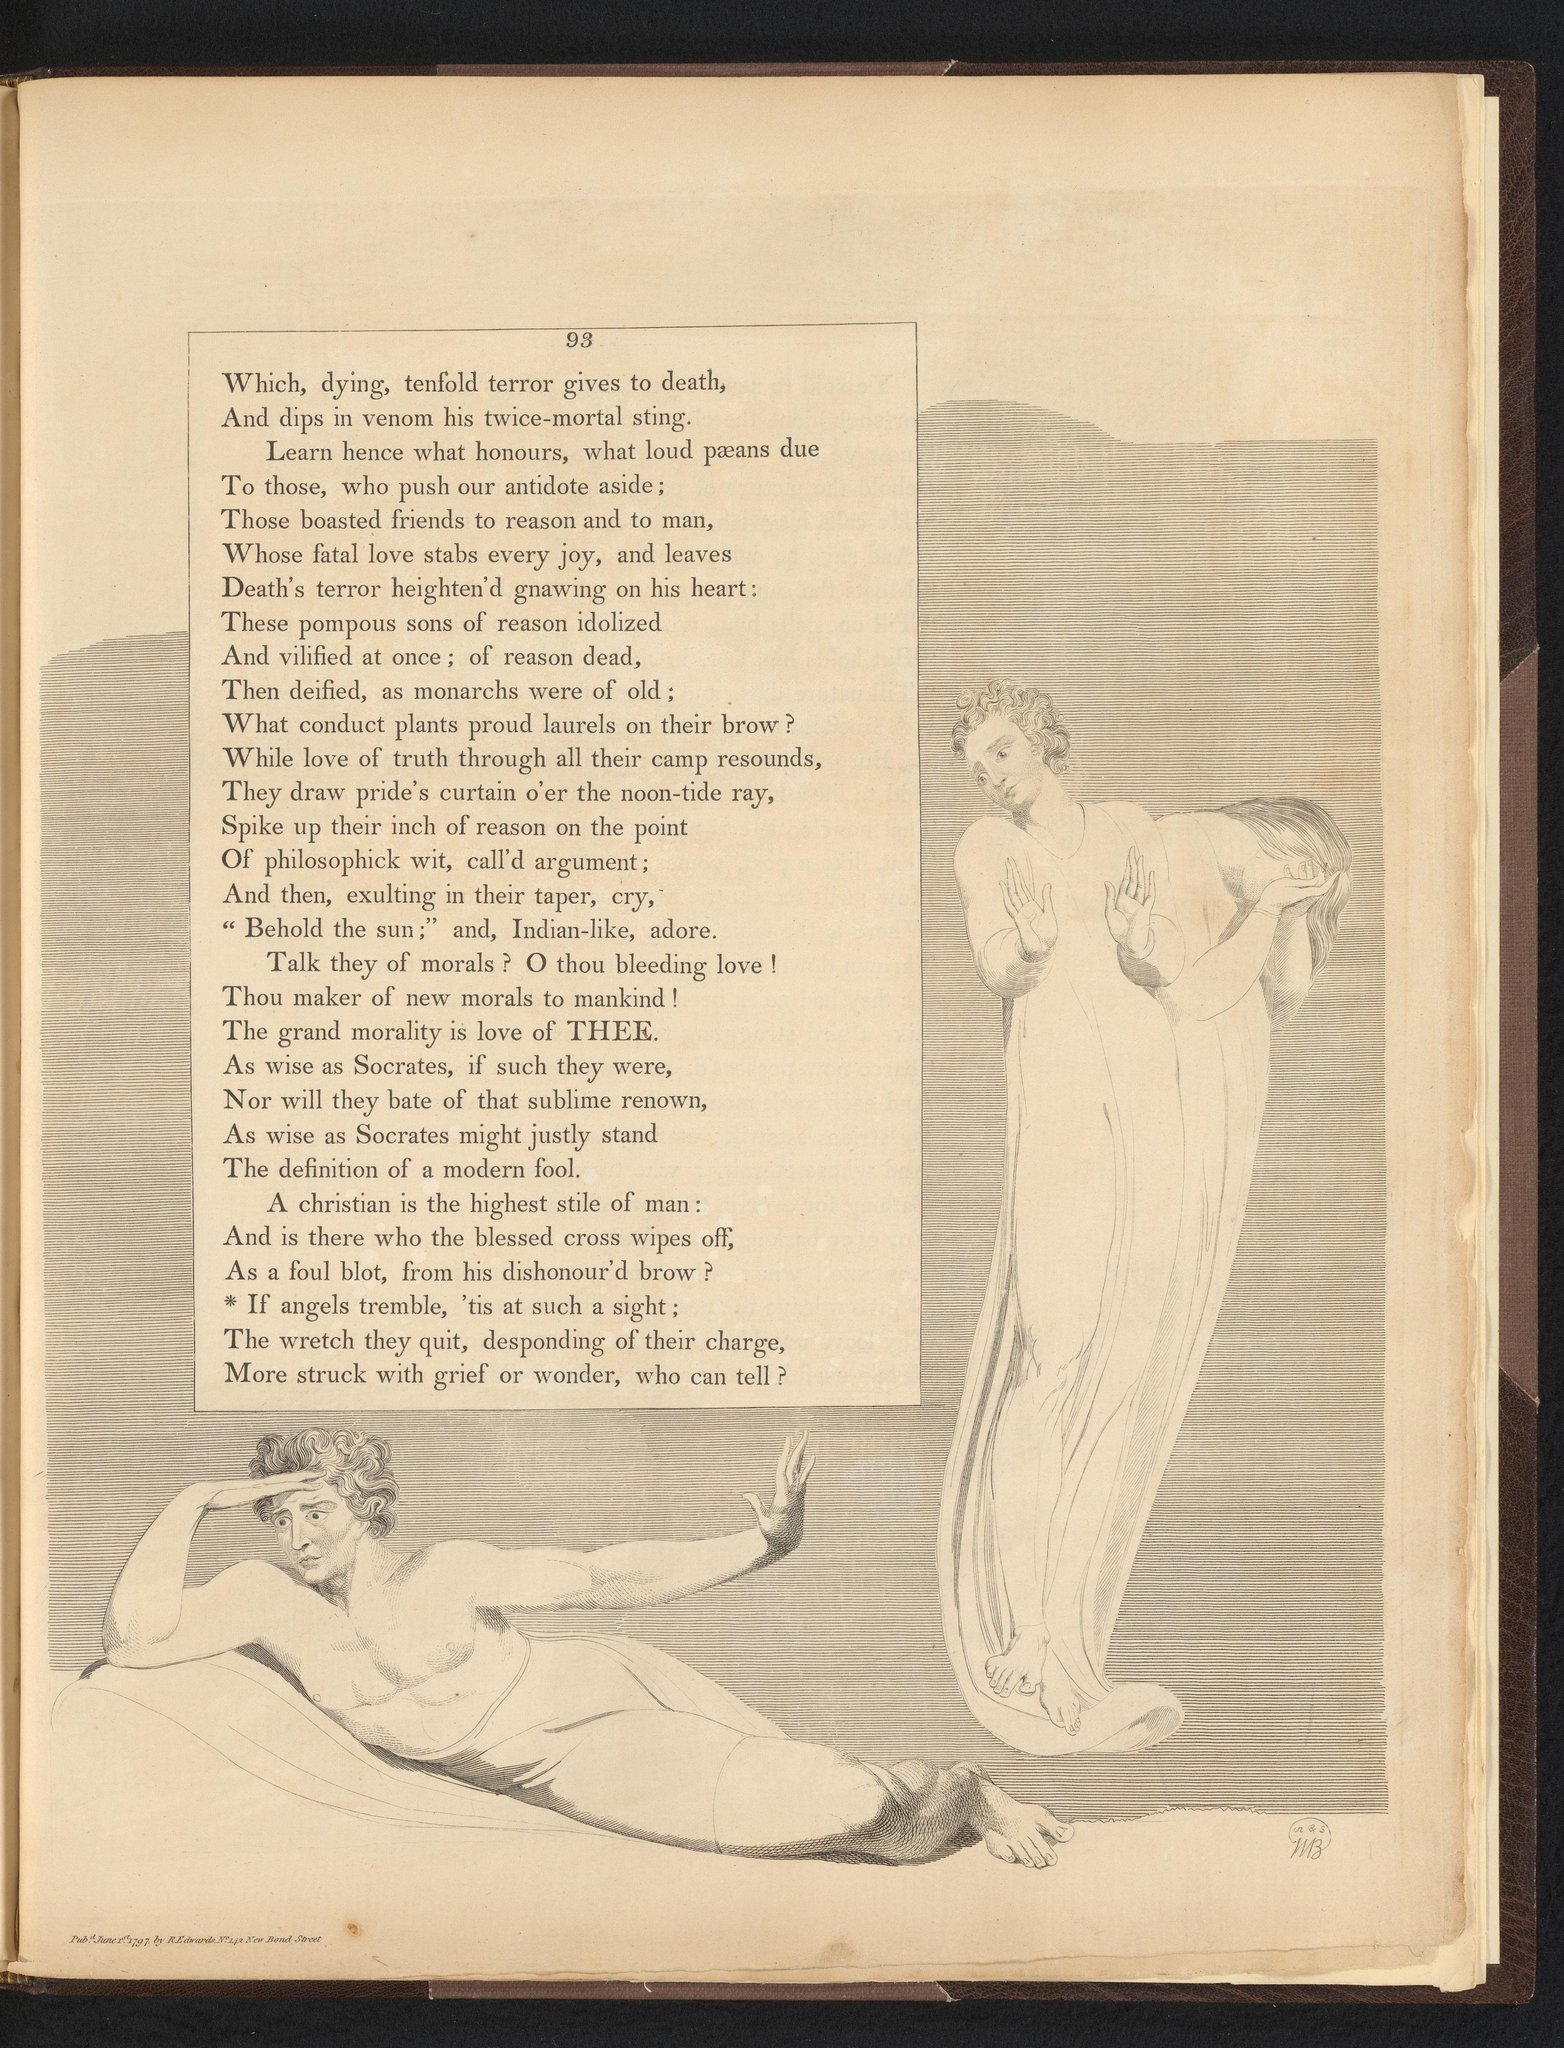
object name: print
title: Liggende man en treurend stel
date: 1796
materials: paper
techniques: engraving, letterpress printing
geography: london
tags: adult woman, adult man, pain, sorrow, sadness; 'dolore', 'dolore di zeusi' (ripa)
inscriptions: : ‘Which, dying, tenfold terror gives to death, (...)’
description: Prent maakt deel uit van een boek, bladzijde 93. Tekst in het Engels op het recto en verso.